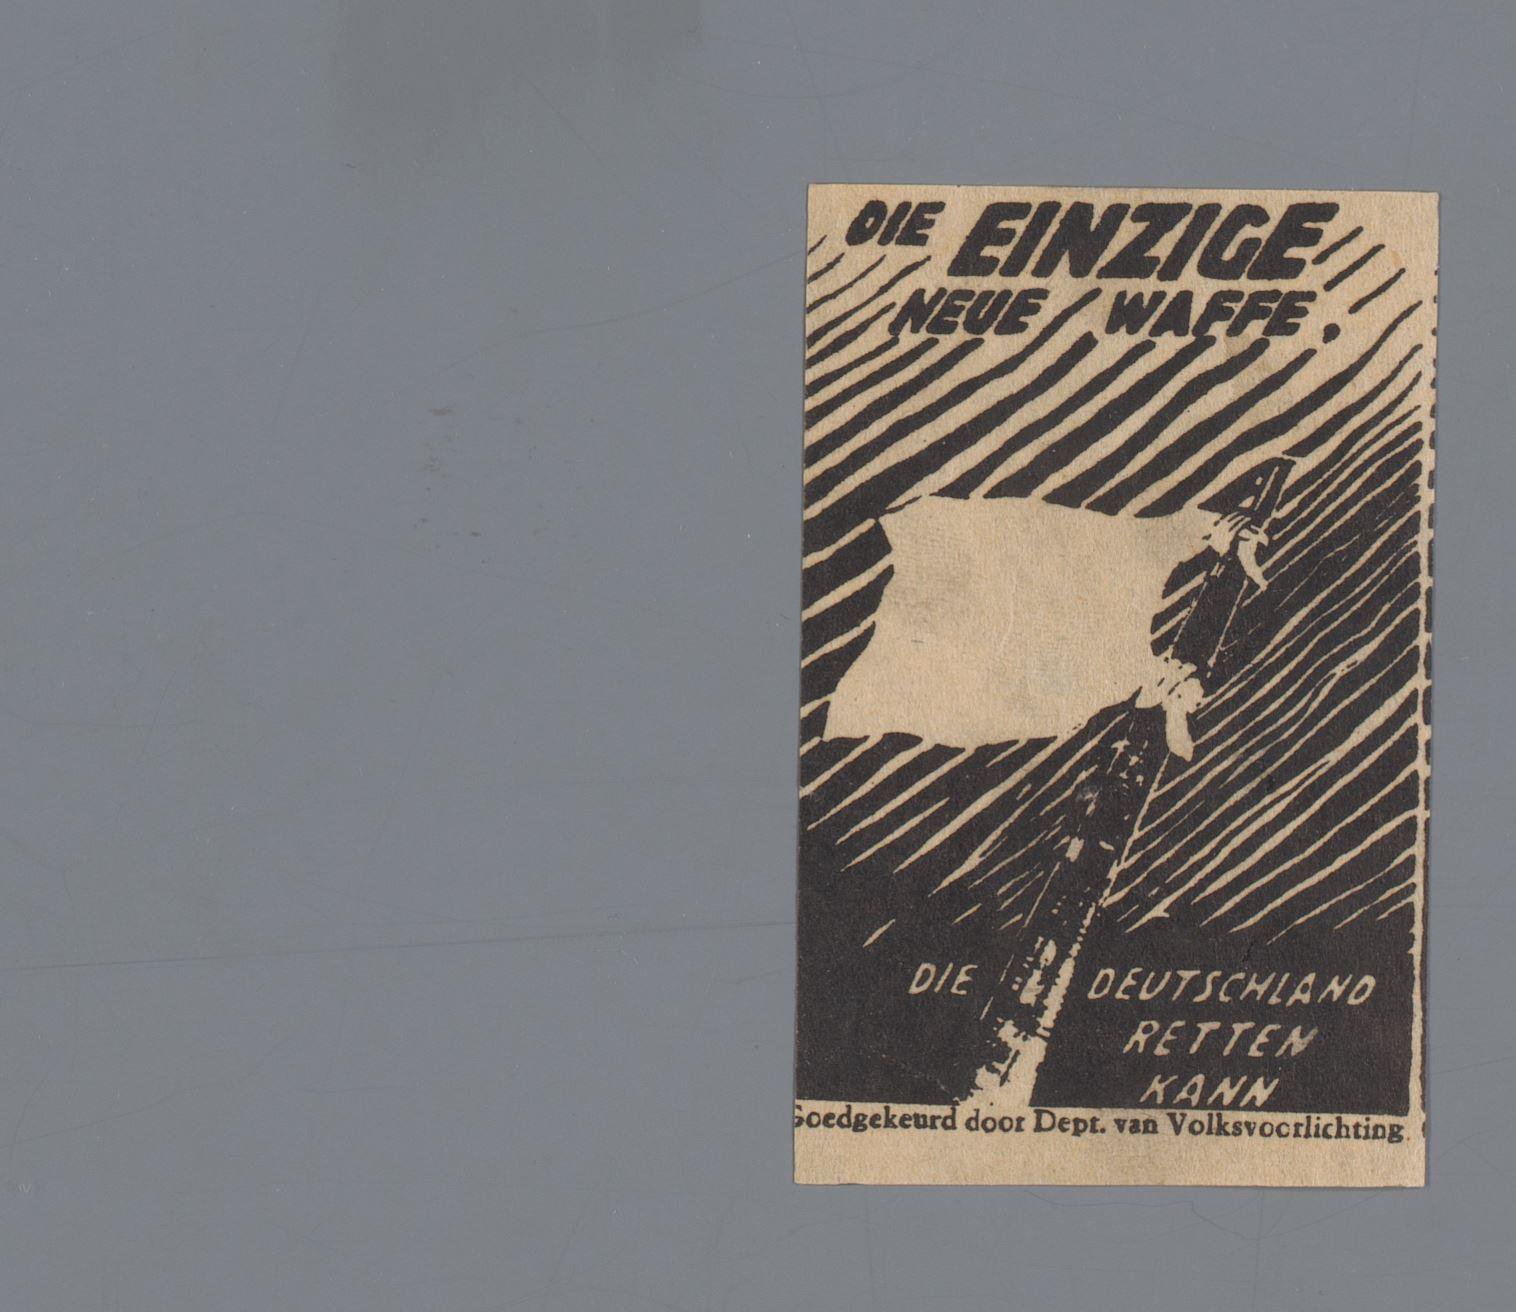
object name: sticker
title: Die einzige neue Waffe die Deutschland retten kann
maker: rob korpershoek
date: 1944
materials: paper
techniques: printing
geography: utrecht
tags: rob korpershoek, netherlands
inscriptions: inscription: ‘DIE EINZIGE NEUE WAFFE’, inscription: ‘Goedgekeurd door Dept. van Volksvoorlichting’, inscription: ‘DIE DEUTSCHLAND RETTEN KANN’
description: Rechthoekig zwart-wit plaatje met lijmlaag op keerzijde. Centraal: afbeelding van voorste deel van geweerloop waaraan witte doek is geknoopt. Op achtergrond diagonale strepen. Midden boven opschrift in zwart, midden onder in wit. Op afsnede: opschrift in zwart. Plaat is afgeknipt van reeks of aan beide zijkanten bijgeknipt.